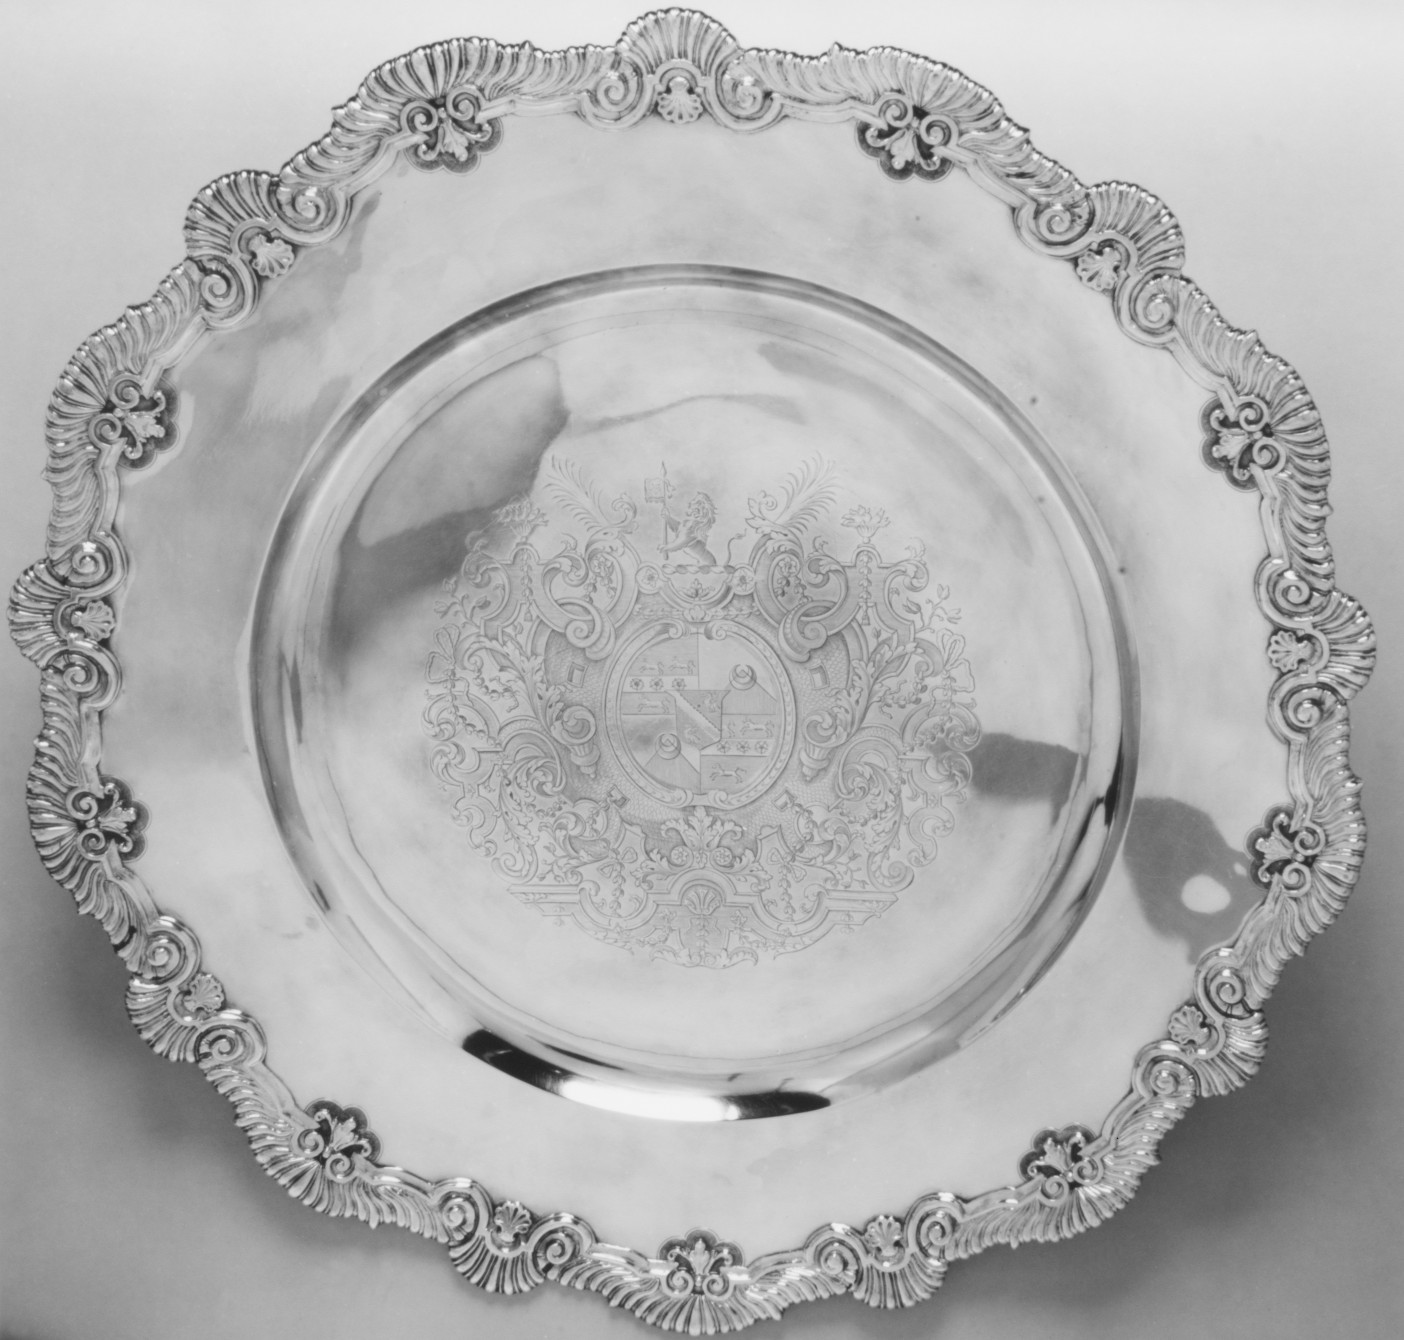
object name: salver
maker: david willaume i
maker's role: maker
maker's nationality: british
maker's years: 1658-1741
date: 1710-1711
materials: silver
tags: lions,coat of arms